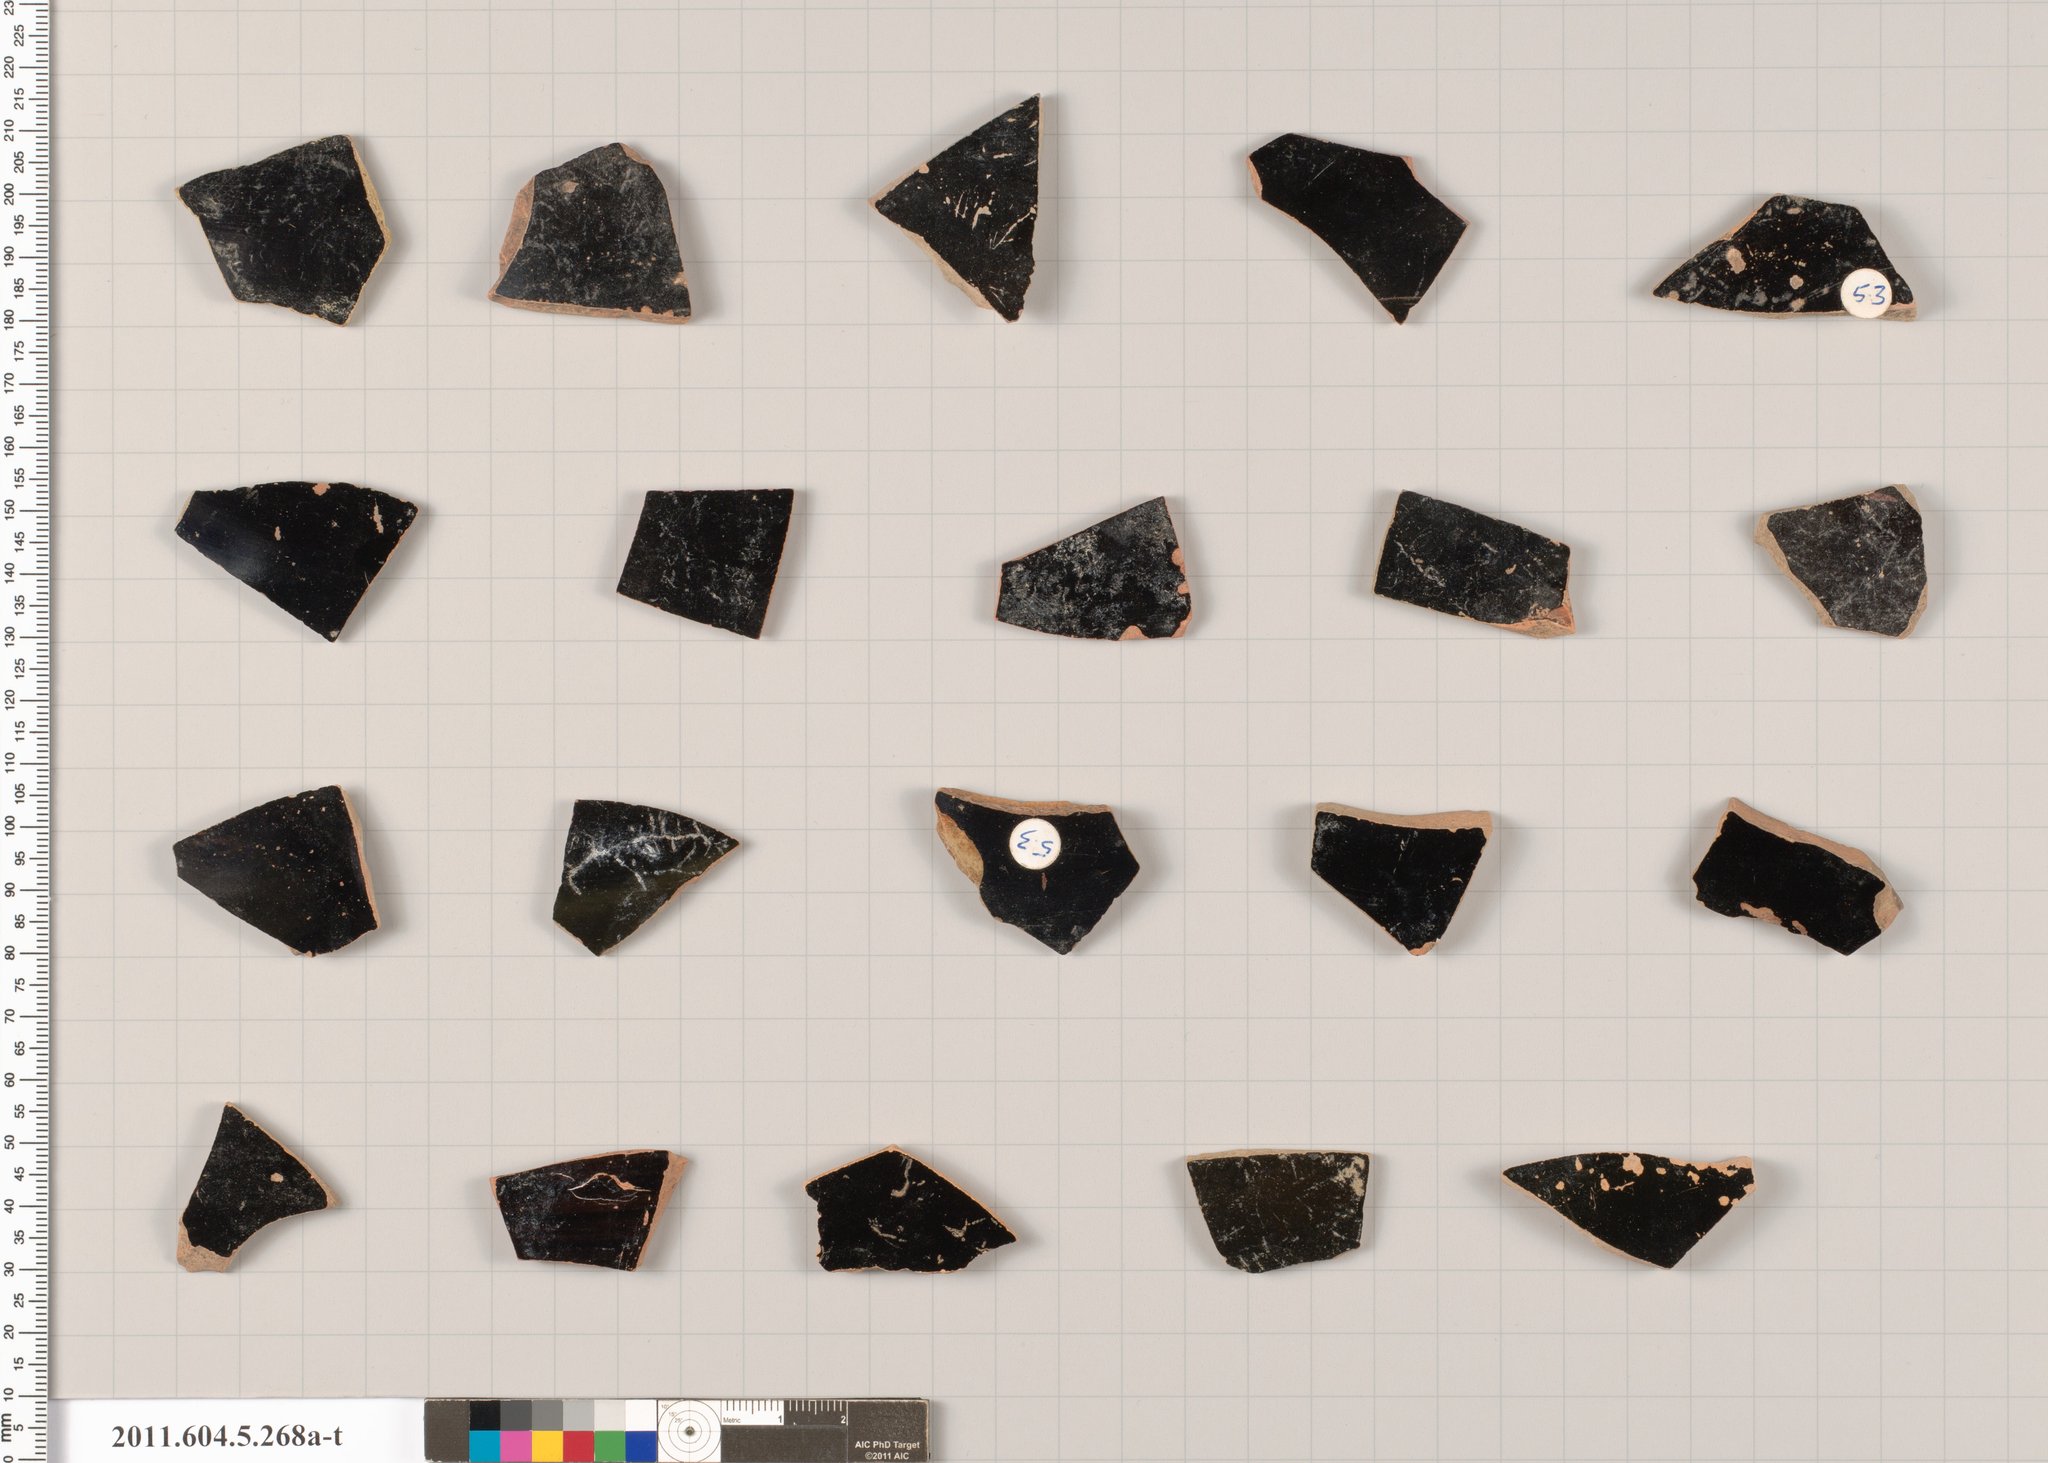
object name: kylix fragment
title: Terracotta fragments of kylikes (drinking cups)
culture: greek, attic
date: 600-401 BCE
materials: terracotta